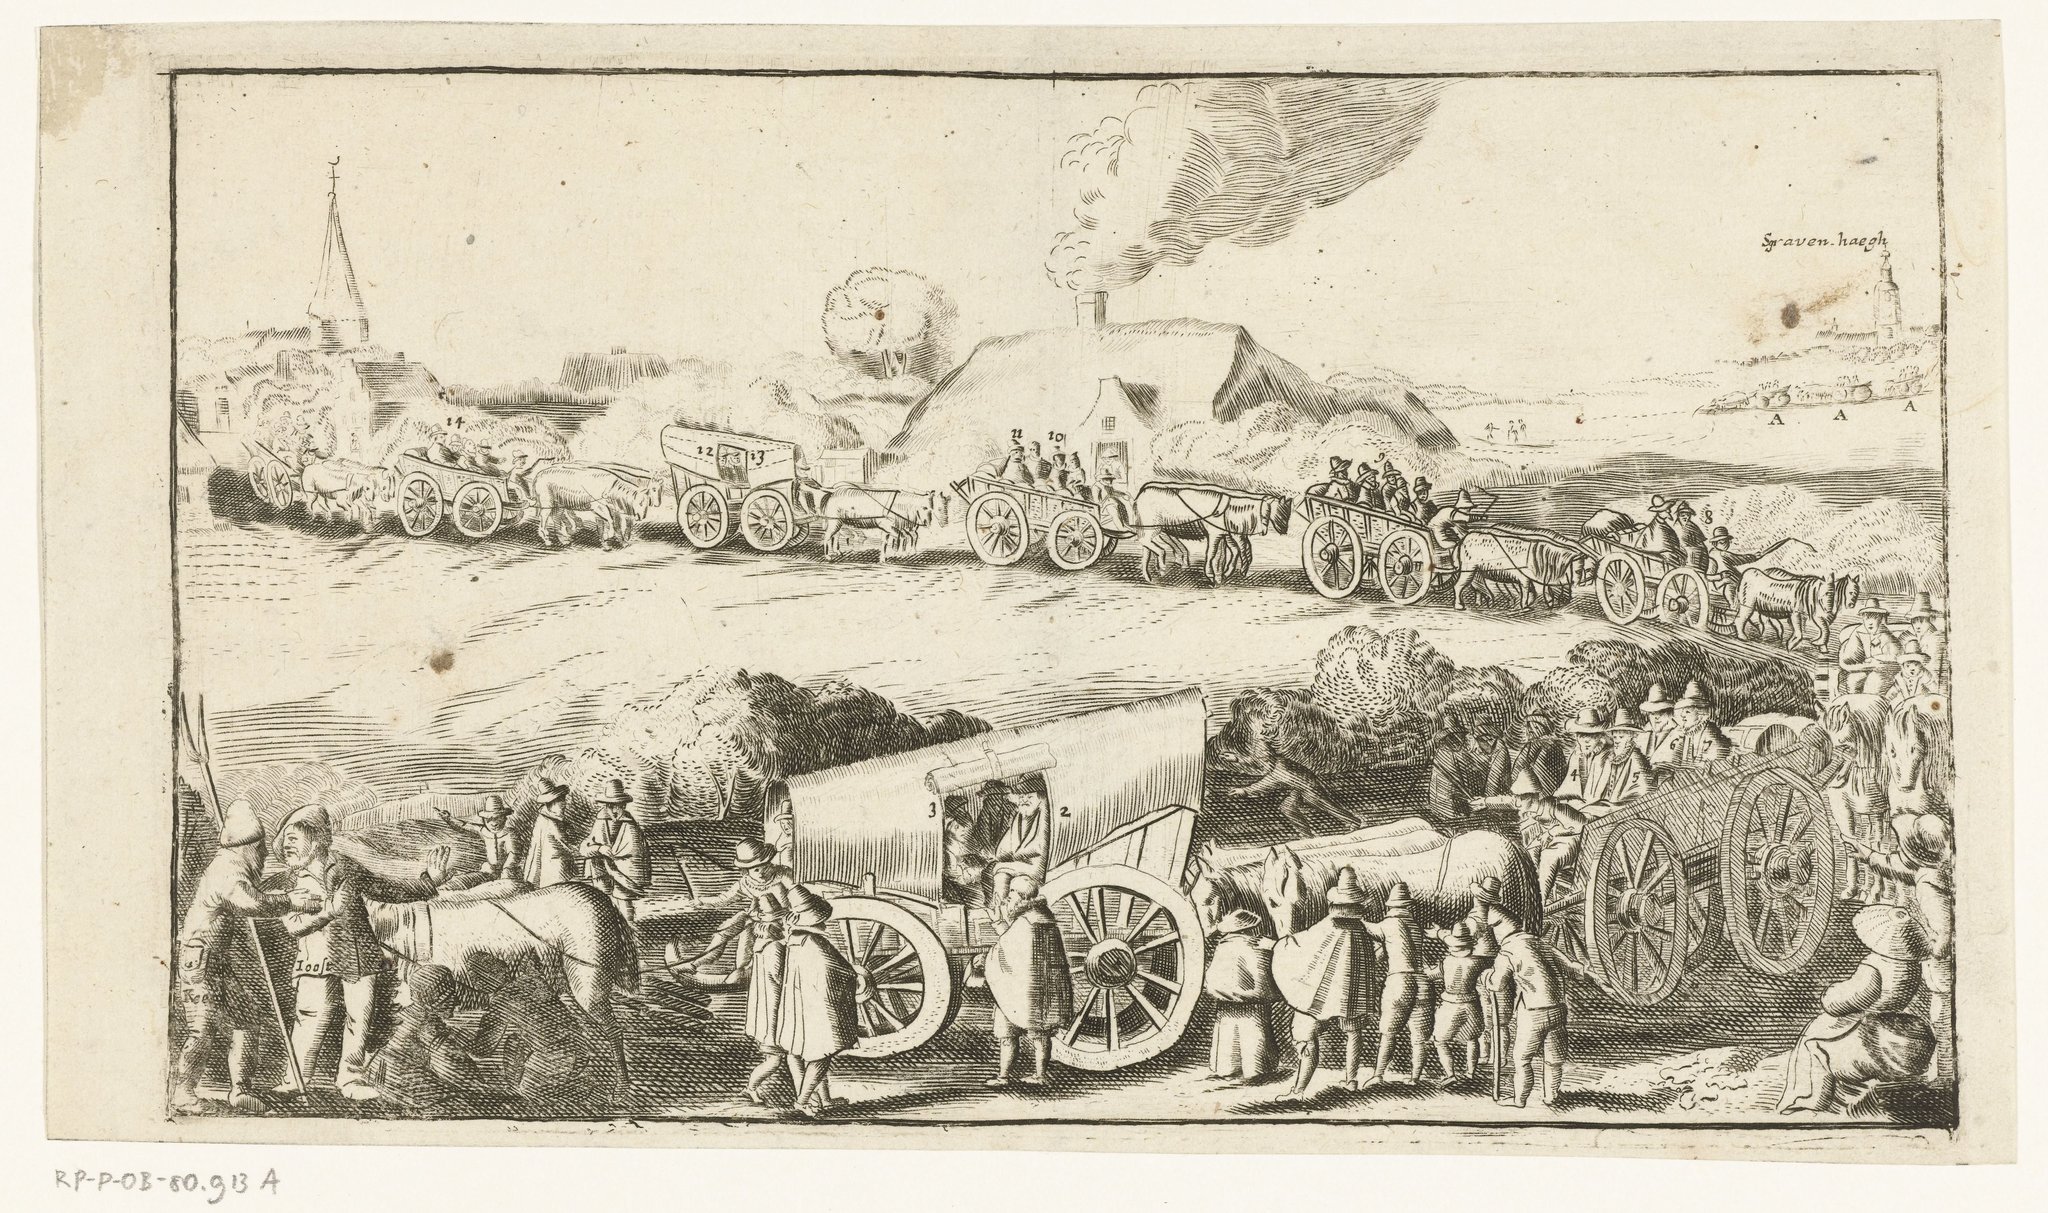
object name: cartoon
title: Uittocht van de remonstrantse predikanten, 1619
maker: Anonymous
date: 1619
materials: paper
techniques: engraving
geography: northern netherlands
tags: banishment, exile, the hague, waalwijk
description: Kopie naar de oorspronkelijke prent van Claes Jansz Visscher (II) (FM 1410). Zie RP-P-OB-80.913B voor het bijbehorende tekstblad.